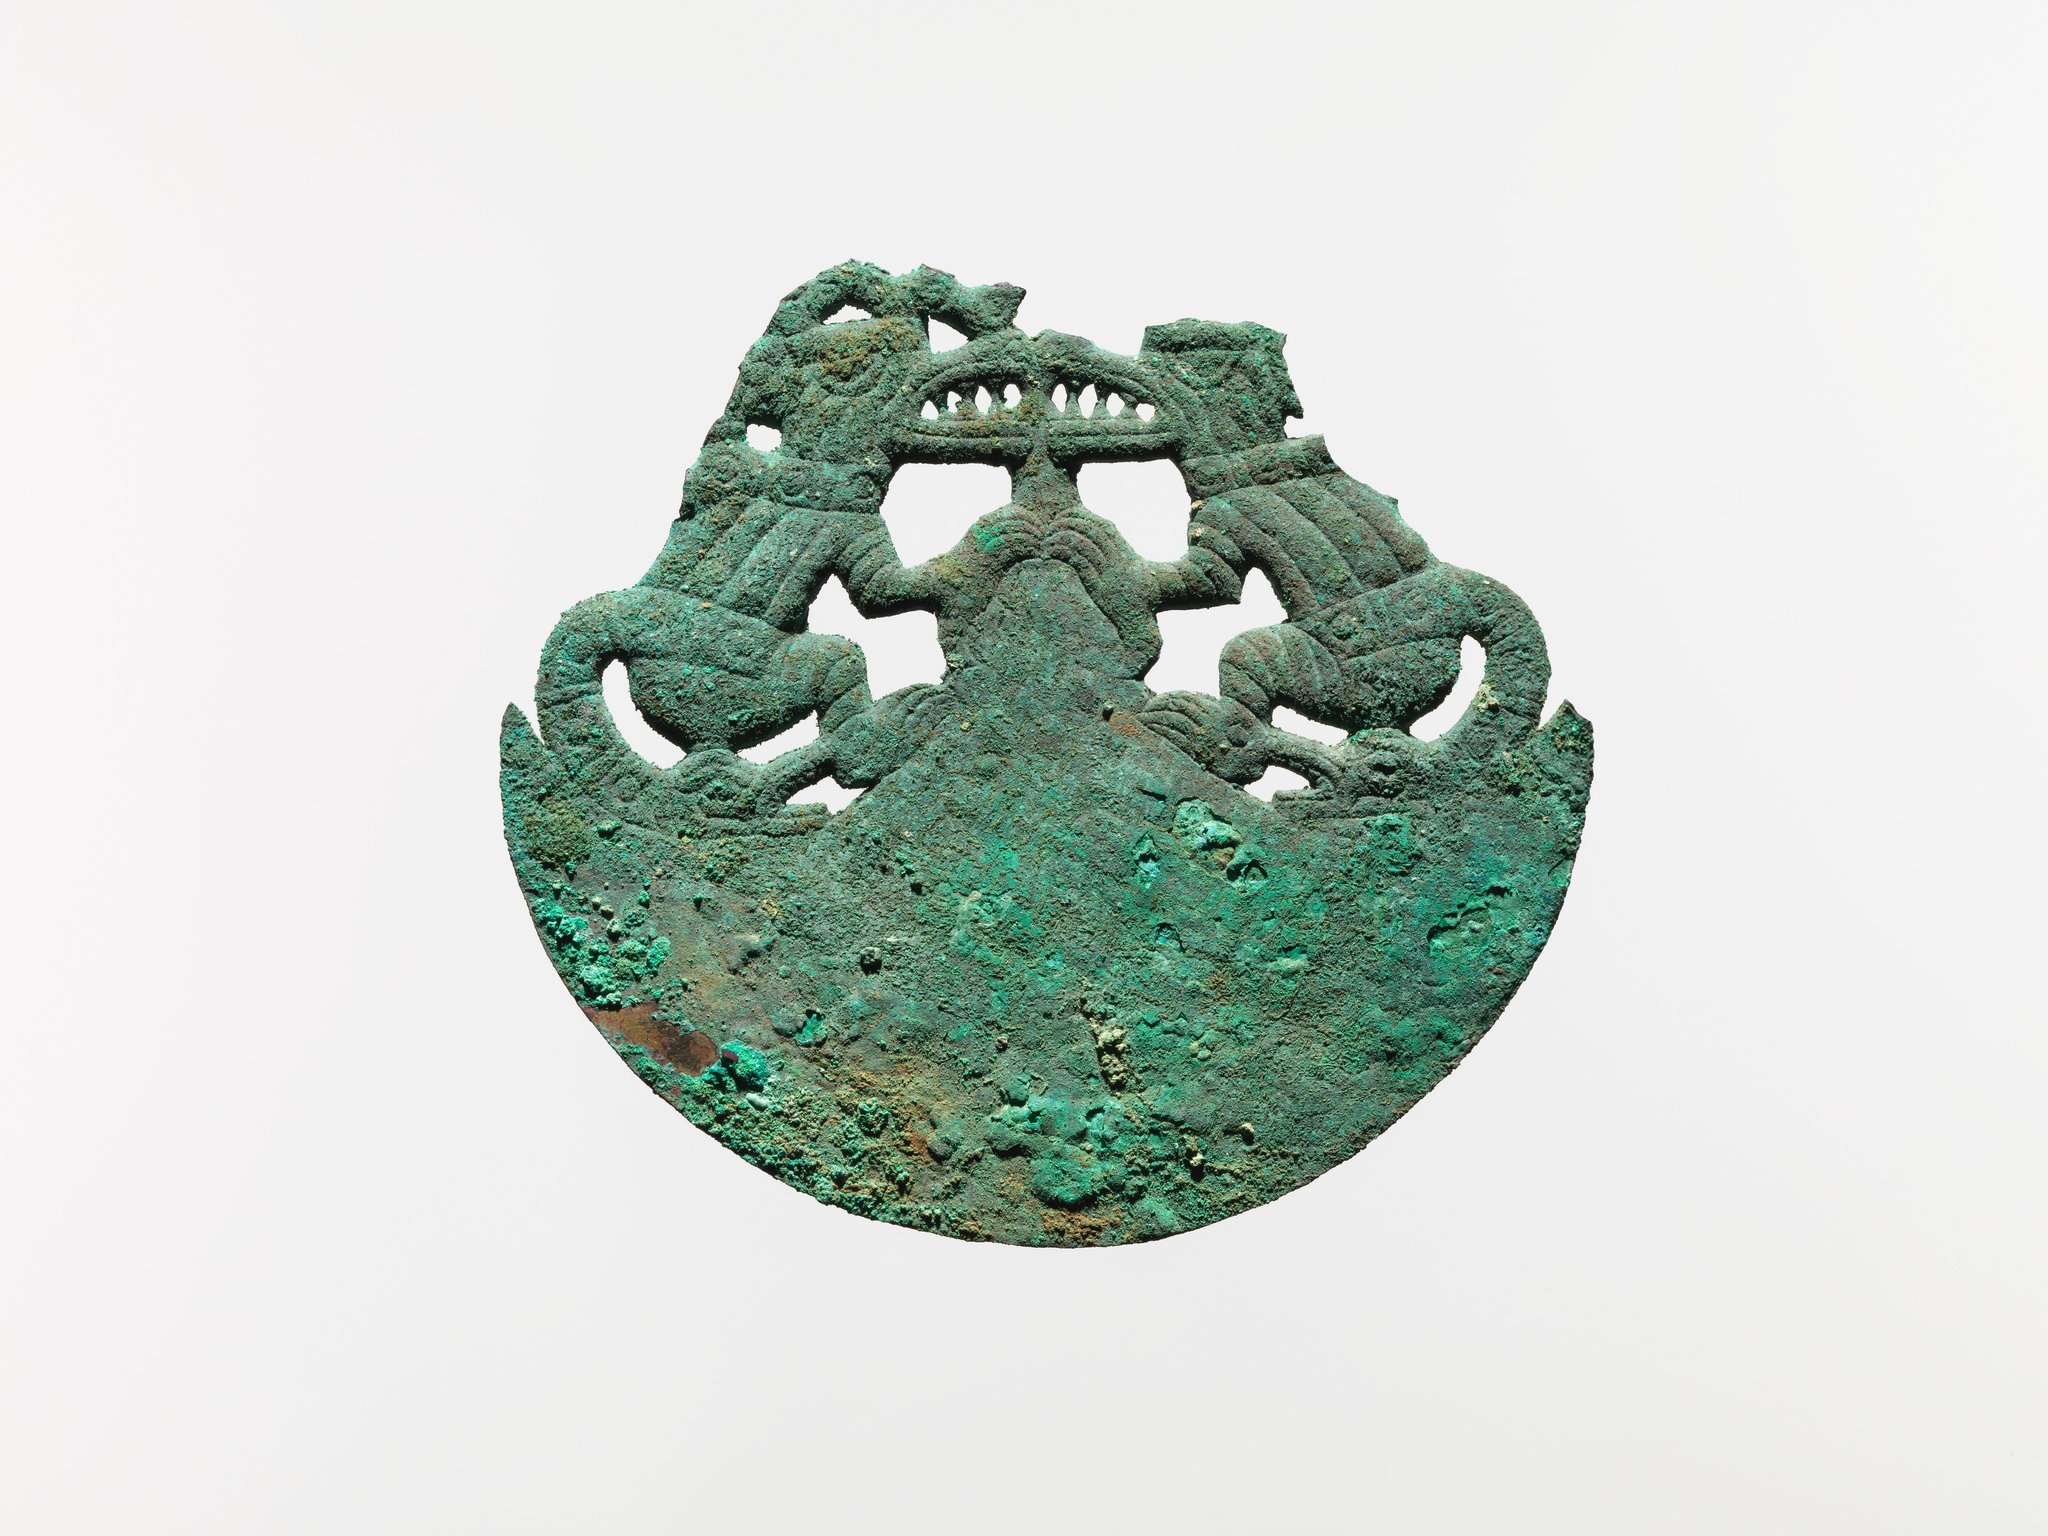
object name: ornament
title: Crescent Ornament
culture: moche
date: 501-700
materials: copper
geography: peru